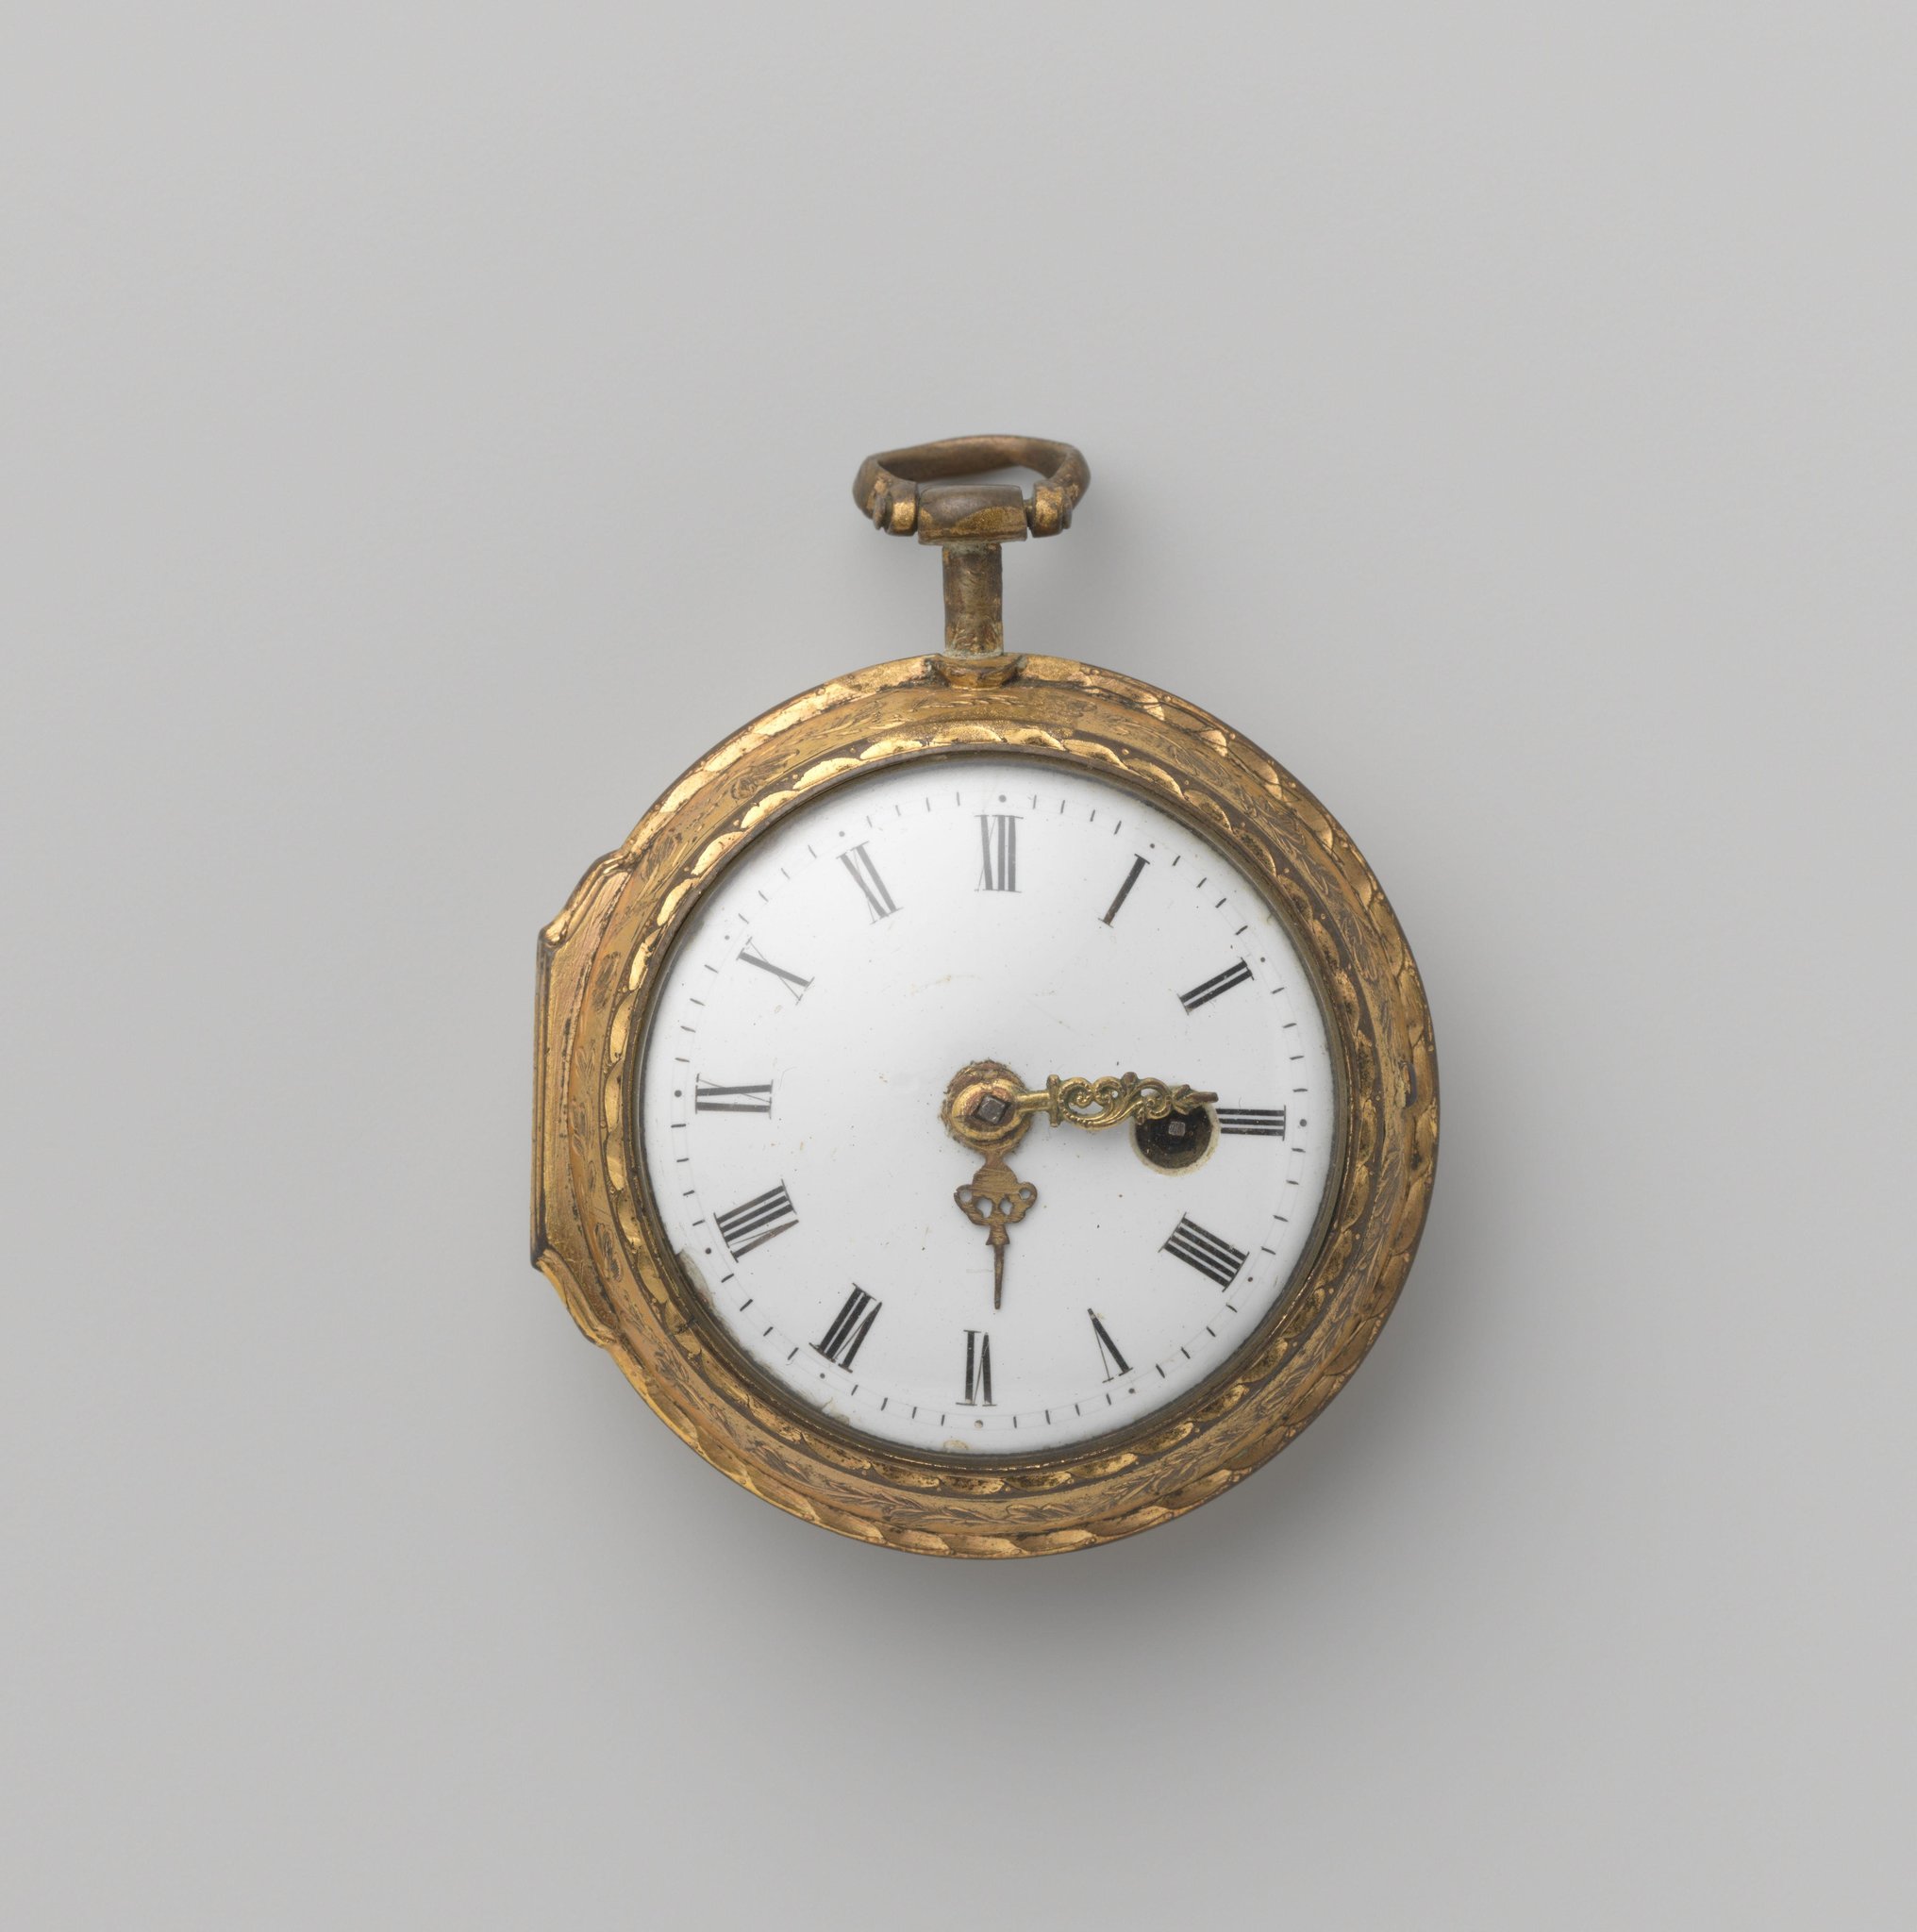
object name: wrist watch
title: Horloge van verguld koper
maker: john worke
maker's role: clockmaker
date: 1775-1800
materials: copper, glass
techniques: gilding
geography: london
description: Verguld koperen horloge met een geëmailleerde wijzerplaat. De beide kastbodems zijn van glas, de randen met bladwerk gegraveerd.